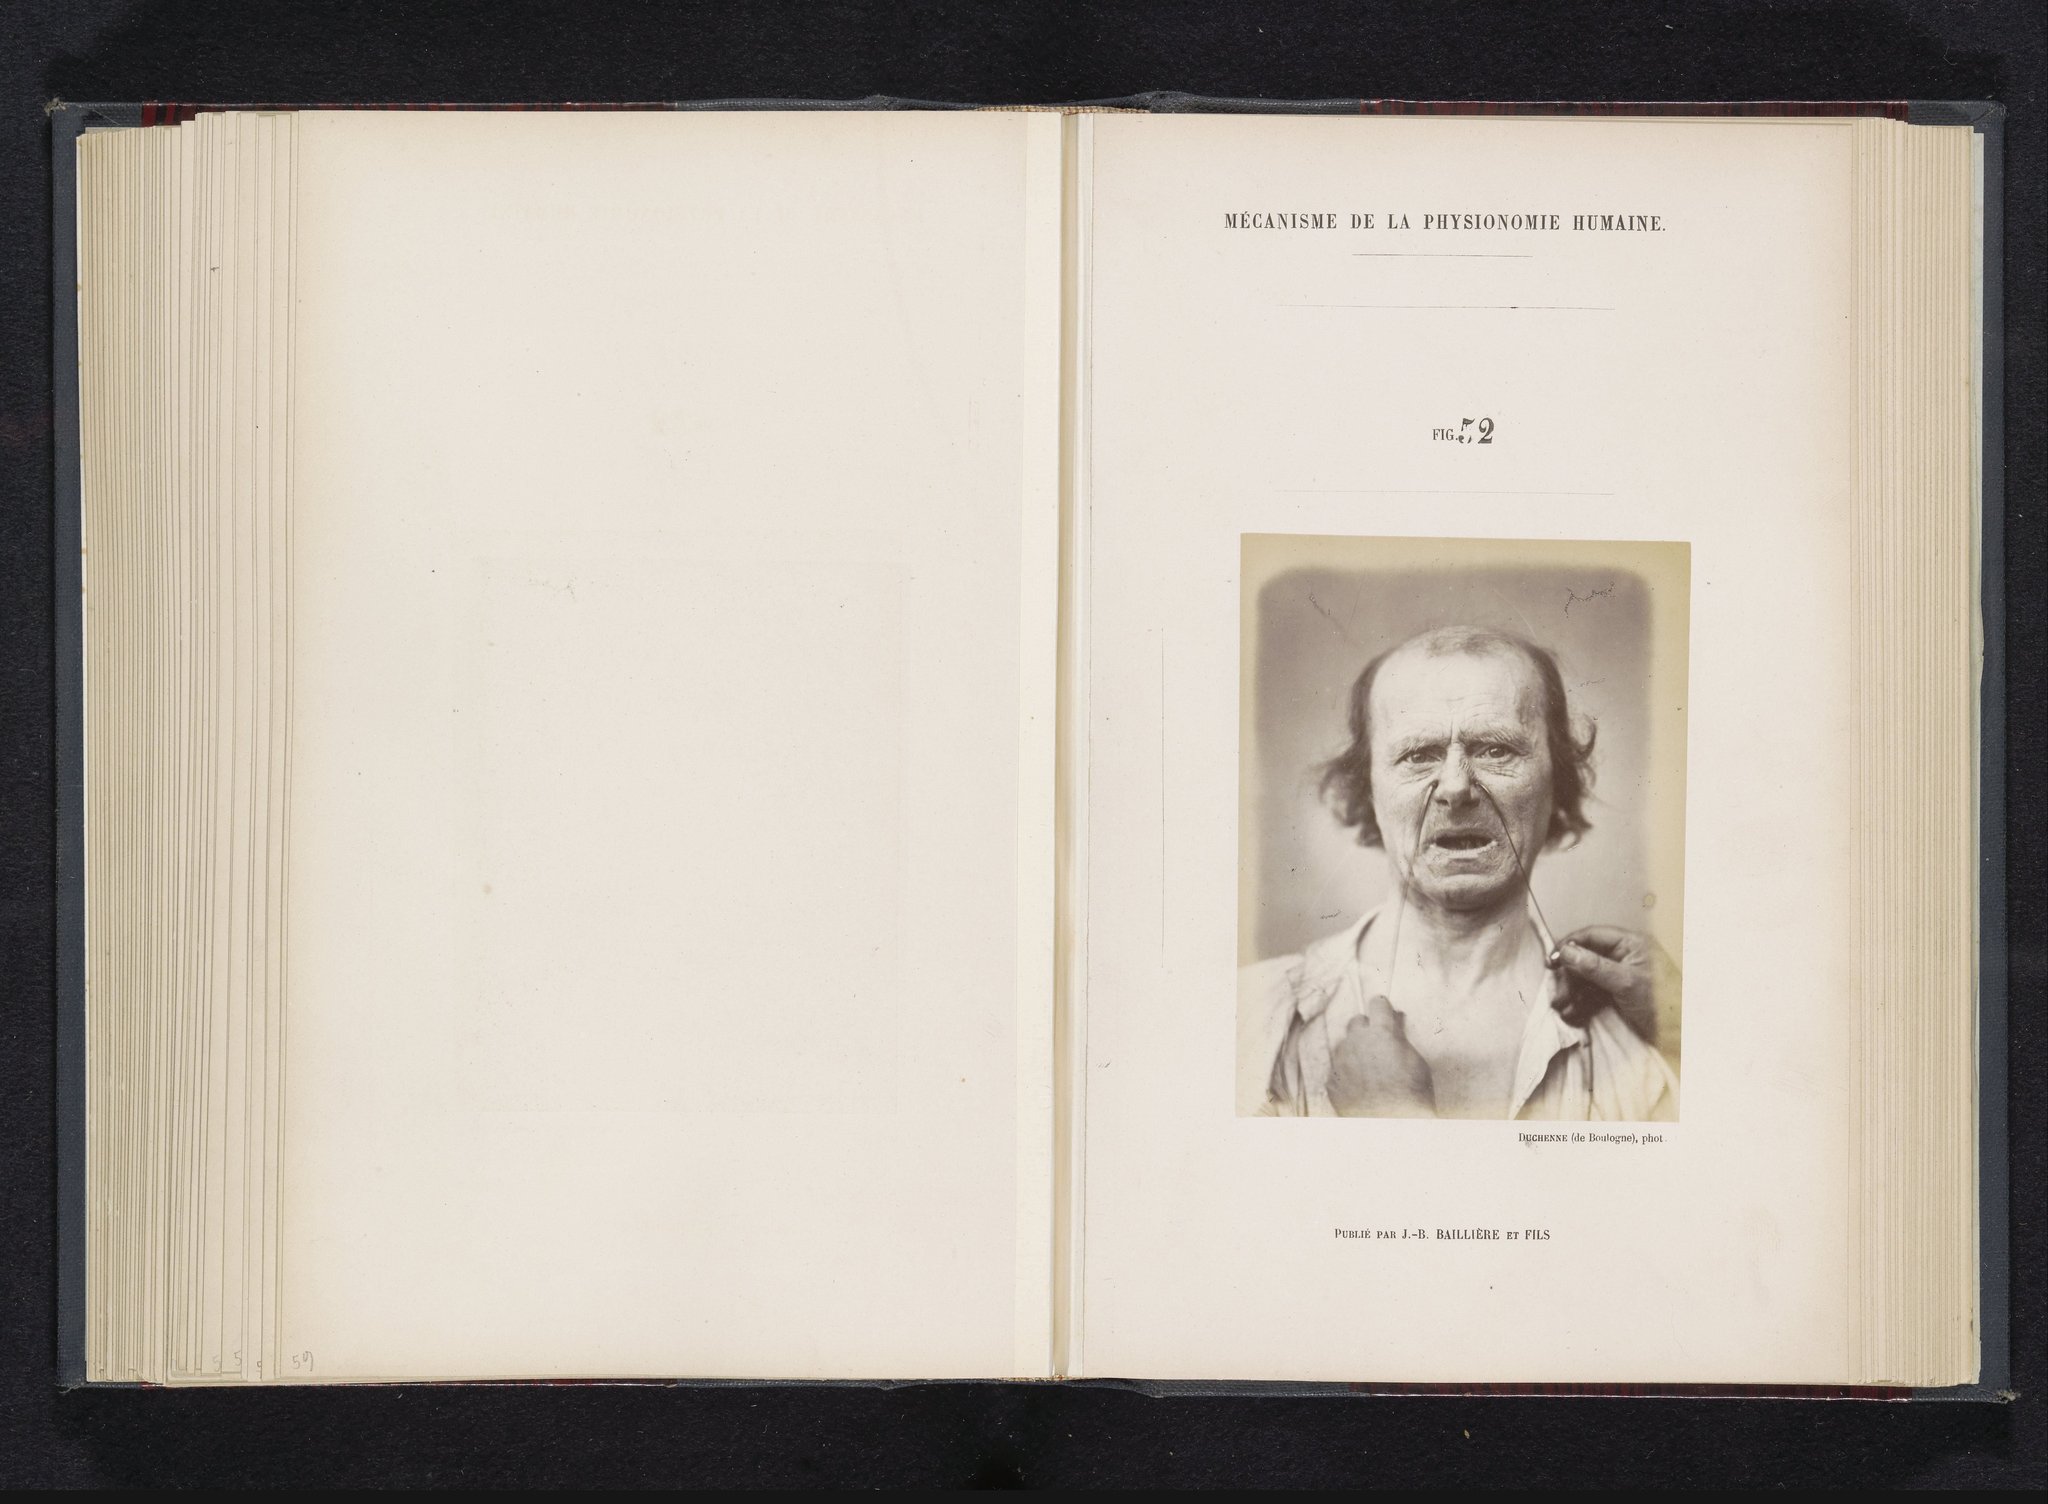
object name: page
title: Portret van een proefpersoon tijdens elektrostimulatie: 'un vieillard'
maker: guillaume benjamin amand duchenne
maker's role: fotograaf, medicus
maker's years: 1806-1875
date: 1860-1862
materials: paper, photographic support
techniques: albumen print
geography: paris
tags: face, physiology and anatomy ~ nervous system, neurology, physiology and anatomy, old man, morphology of facial expression, physiognomy, experiment, test ~ science and technology, france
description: Ongenummerde pagina met foto 52 uit Mécanisme de la physionomie humaine ou analyse électro-physiologique de l'expression des passions (Atlas).